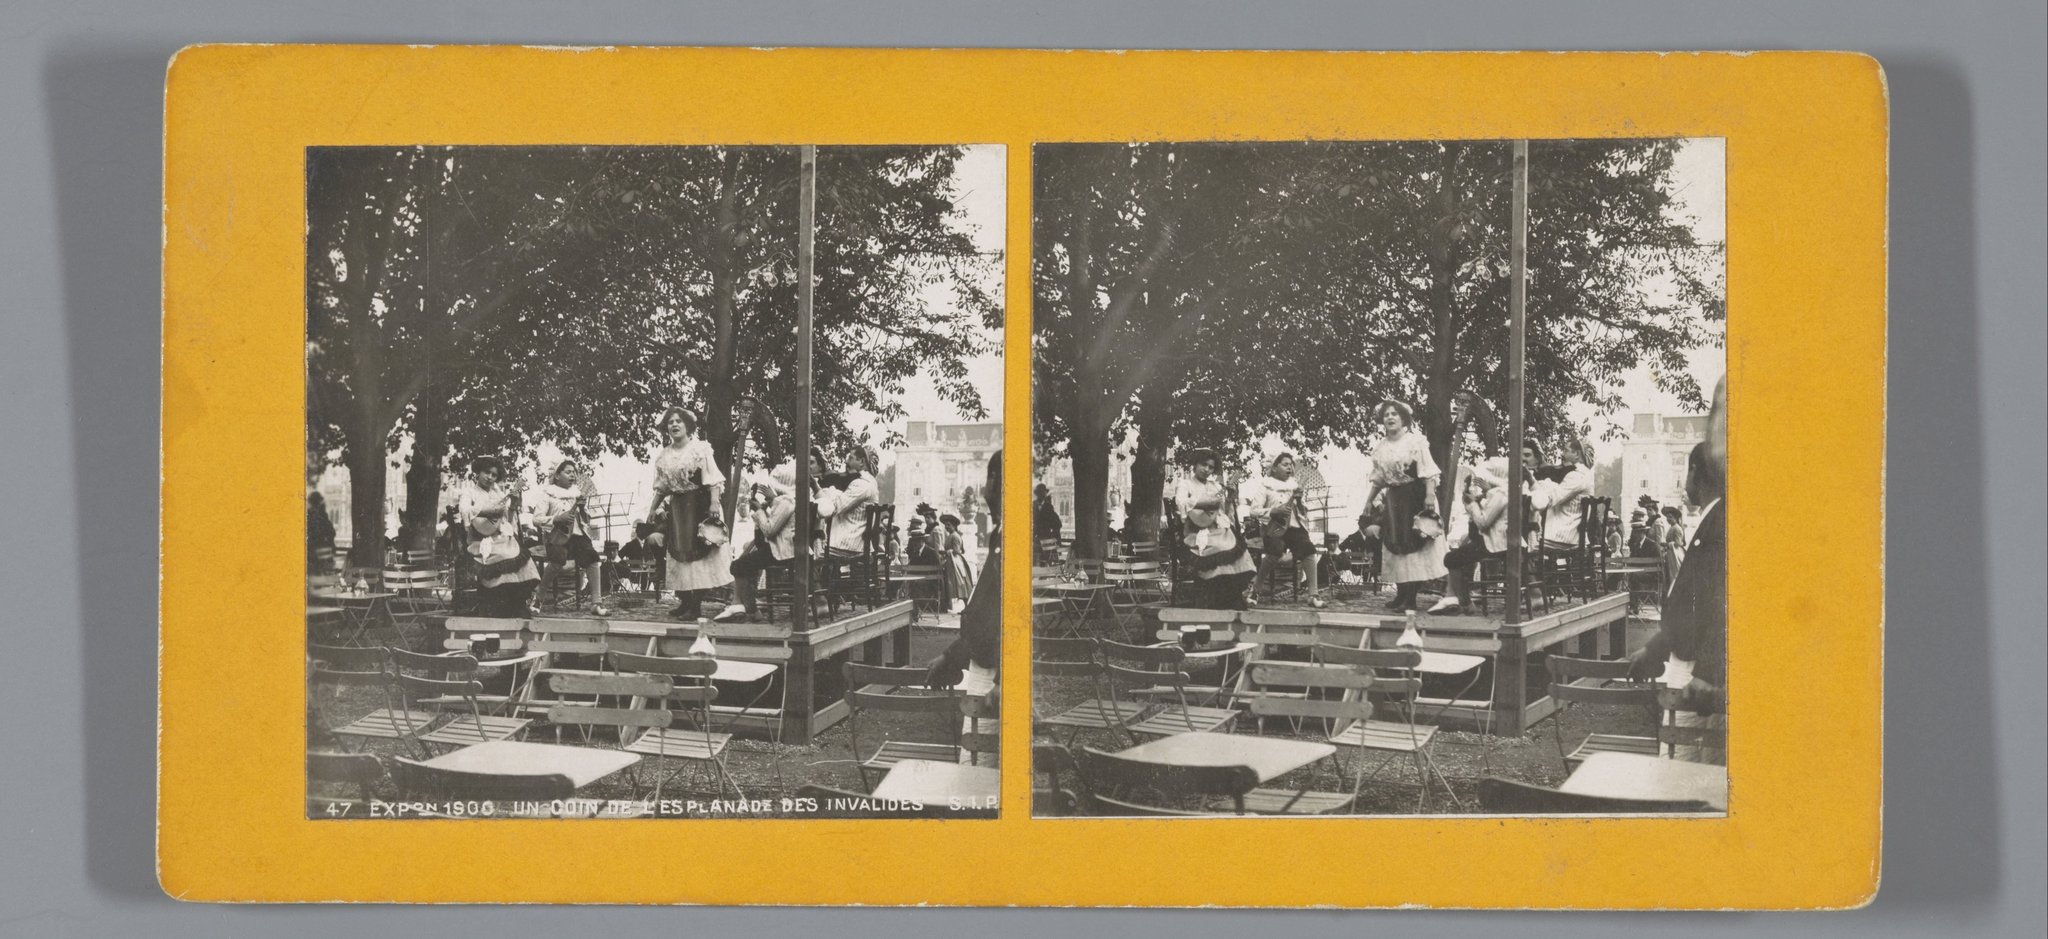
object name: stereograph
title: Muzikanten op een terras aan de Esplanade des Invalides, tijdens de Wereldtentoonstelling van 1900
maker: Anonymous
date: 1900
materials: paper, cardboard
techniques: gelatin silver print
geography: paris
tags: musician - cc - out of doors, tea garden, garden restaurant, paris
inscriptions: number: ‘47’